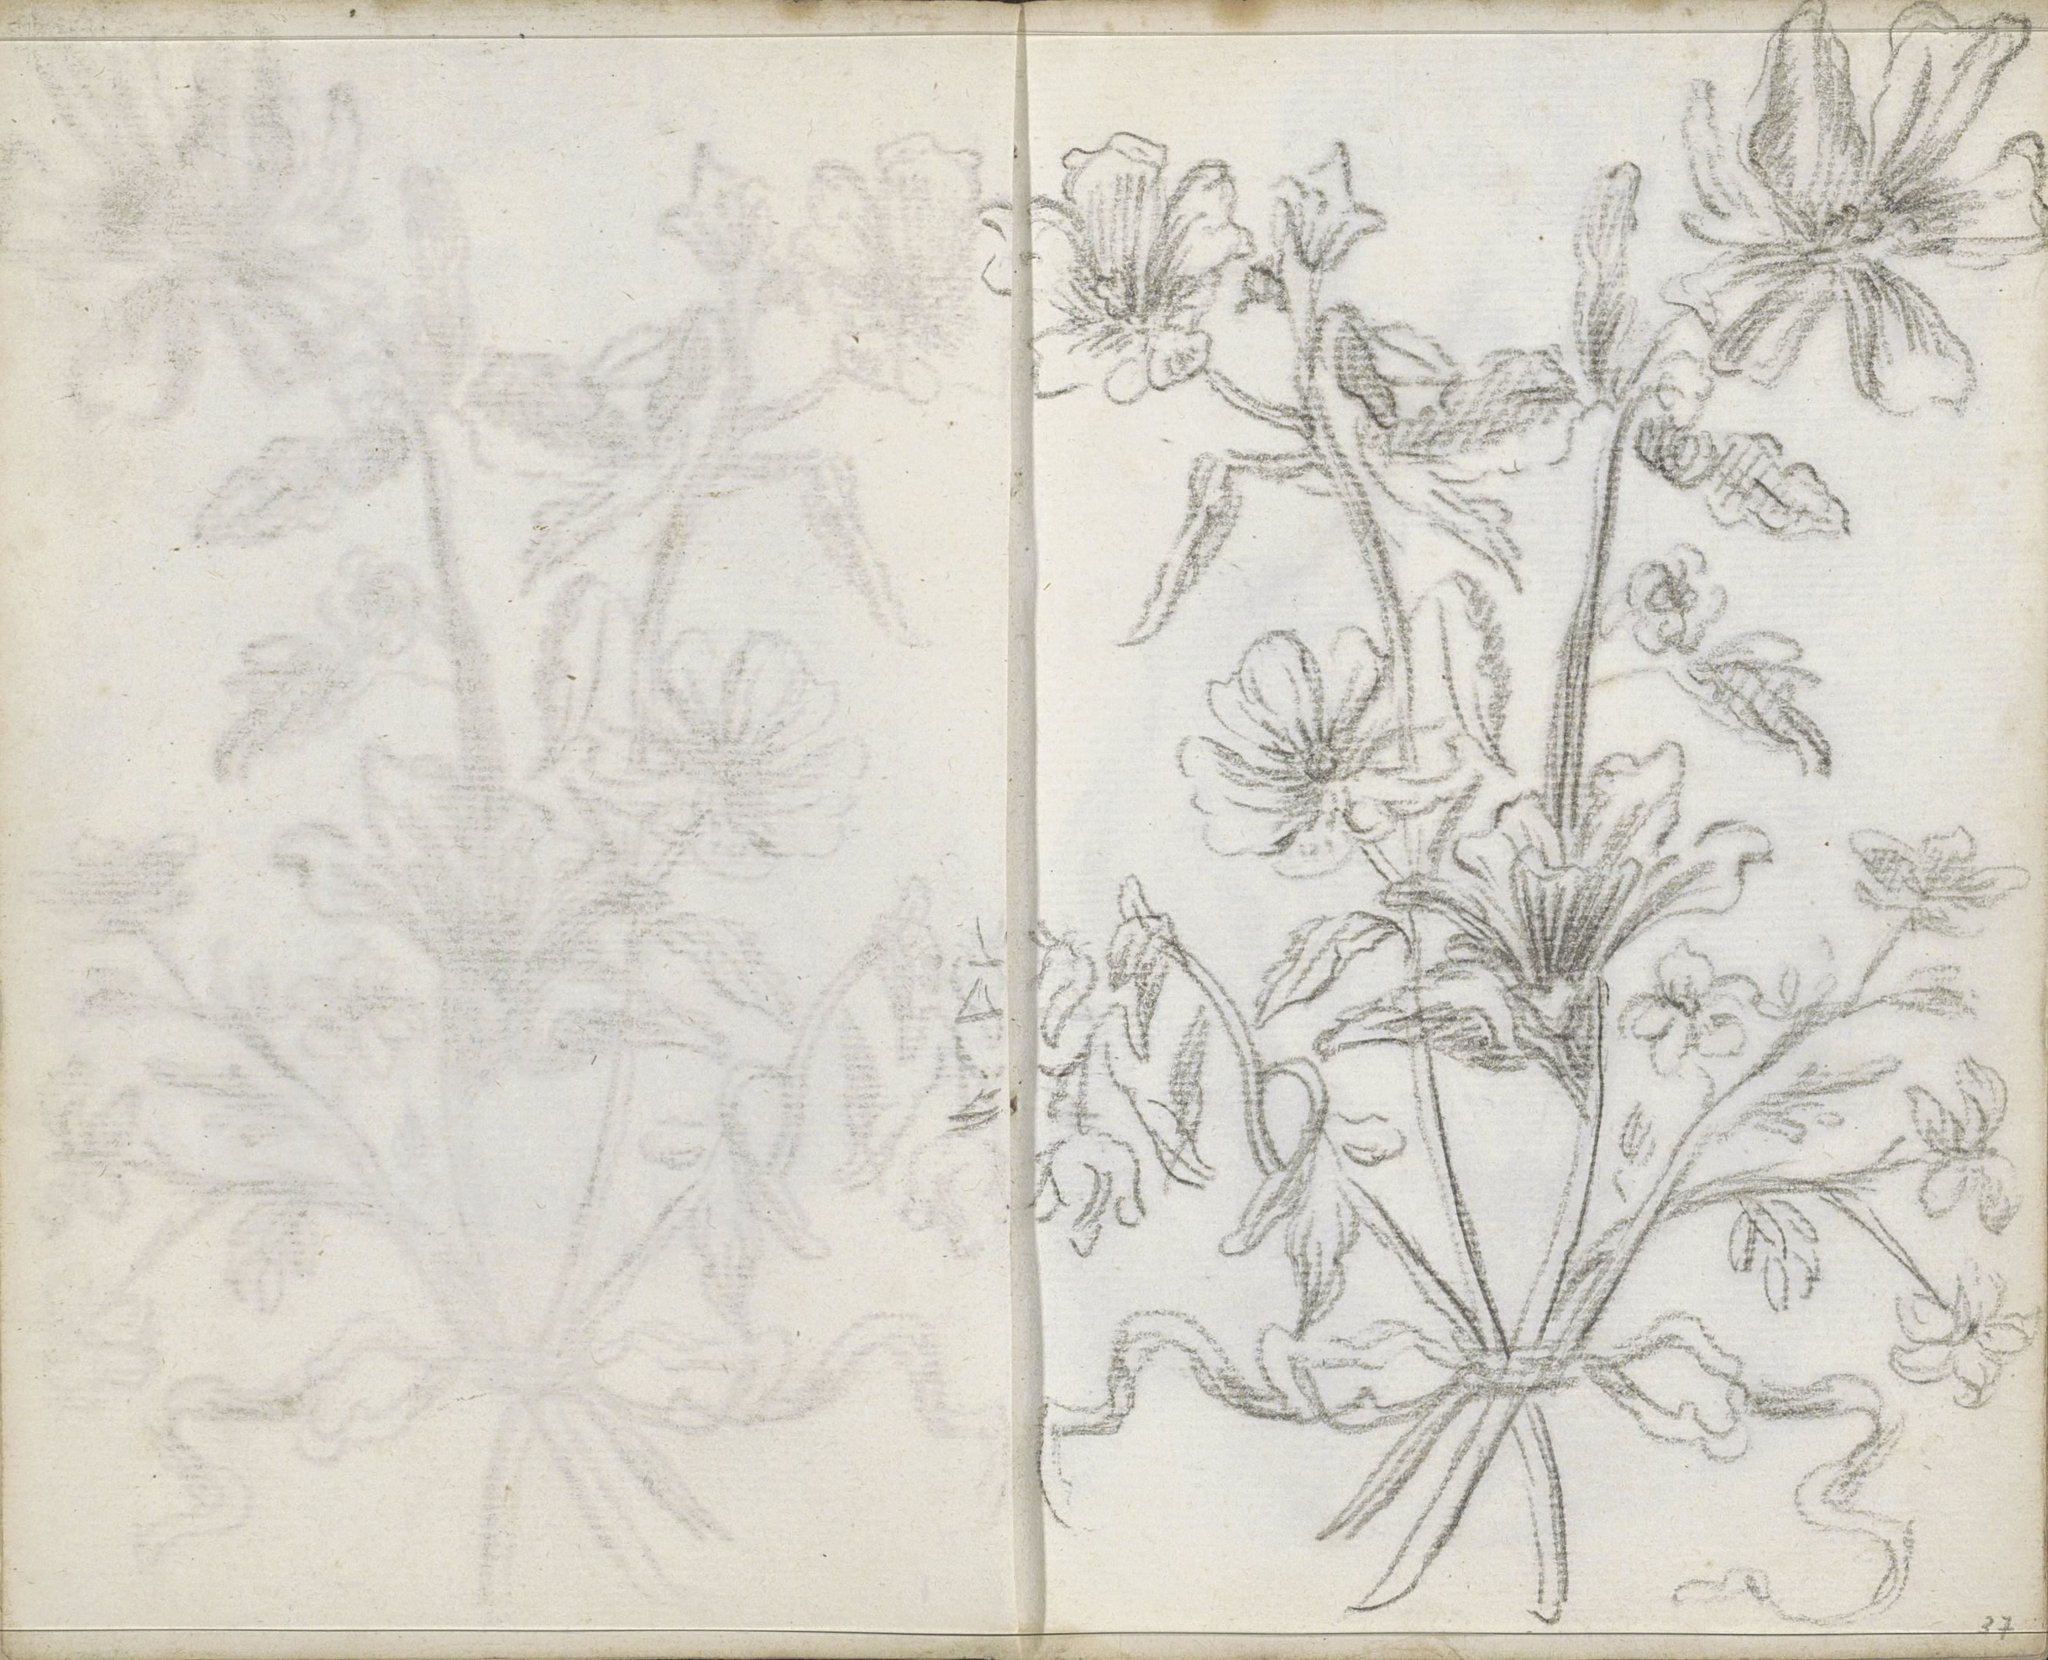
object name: sketchbook leaf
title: Boeket met bloemen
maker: petrus johannes van reysschoot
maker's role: draughtsman, print maker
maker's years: 1702-1772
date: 1710-1772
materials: chalk, paper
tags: cut flowers; nosegay, bunch of flowers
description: Blad 36 verso en 37 recto uit een schetsboek met 105 bladen.